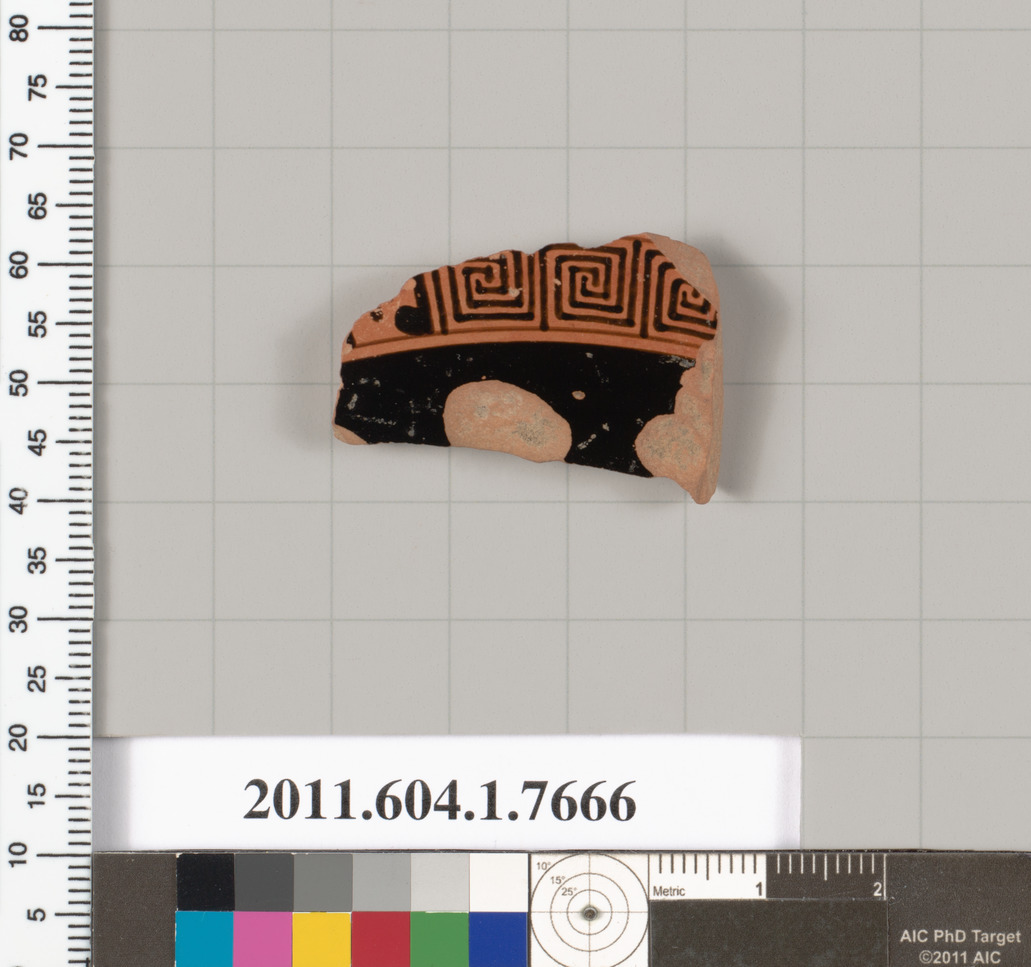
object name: kylix fragment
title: Terracotta fragment of a kylix (drinking cup)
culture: greek, attic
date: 460-450 BCE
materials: terracotta